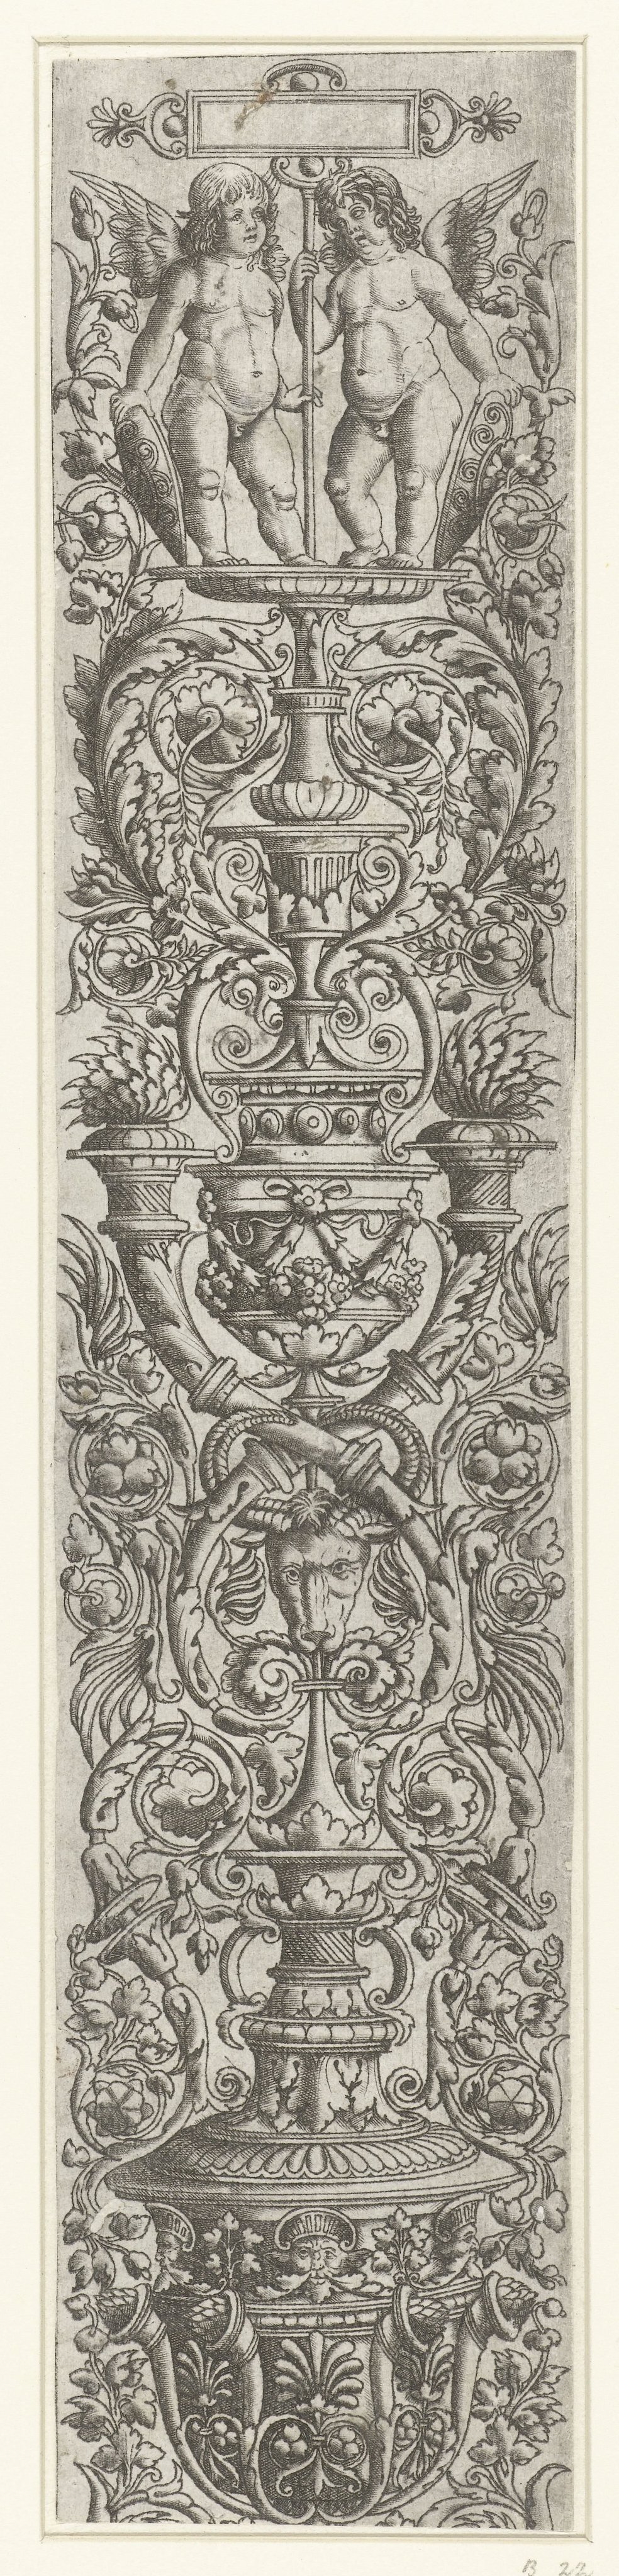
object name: print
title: Fragment van kandelaber met vazen en bladranken bekroond door twee putti met schilden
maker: giampietrino birago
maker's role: print maker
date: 1500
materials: paper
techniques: engraving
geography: italy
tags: cupids: 'amores', 'amoretti', 'putti', ornament derived from plant forms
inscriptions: collector's mark: Lugt 2760, collector's mark: Lugt 2228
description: Prent maakt deel uit van een serie met twaalf ornament panelen.